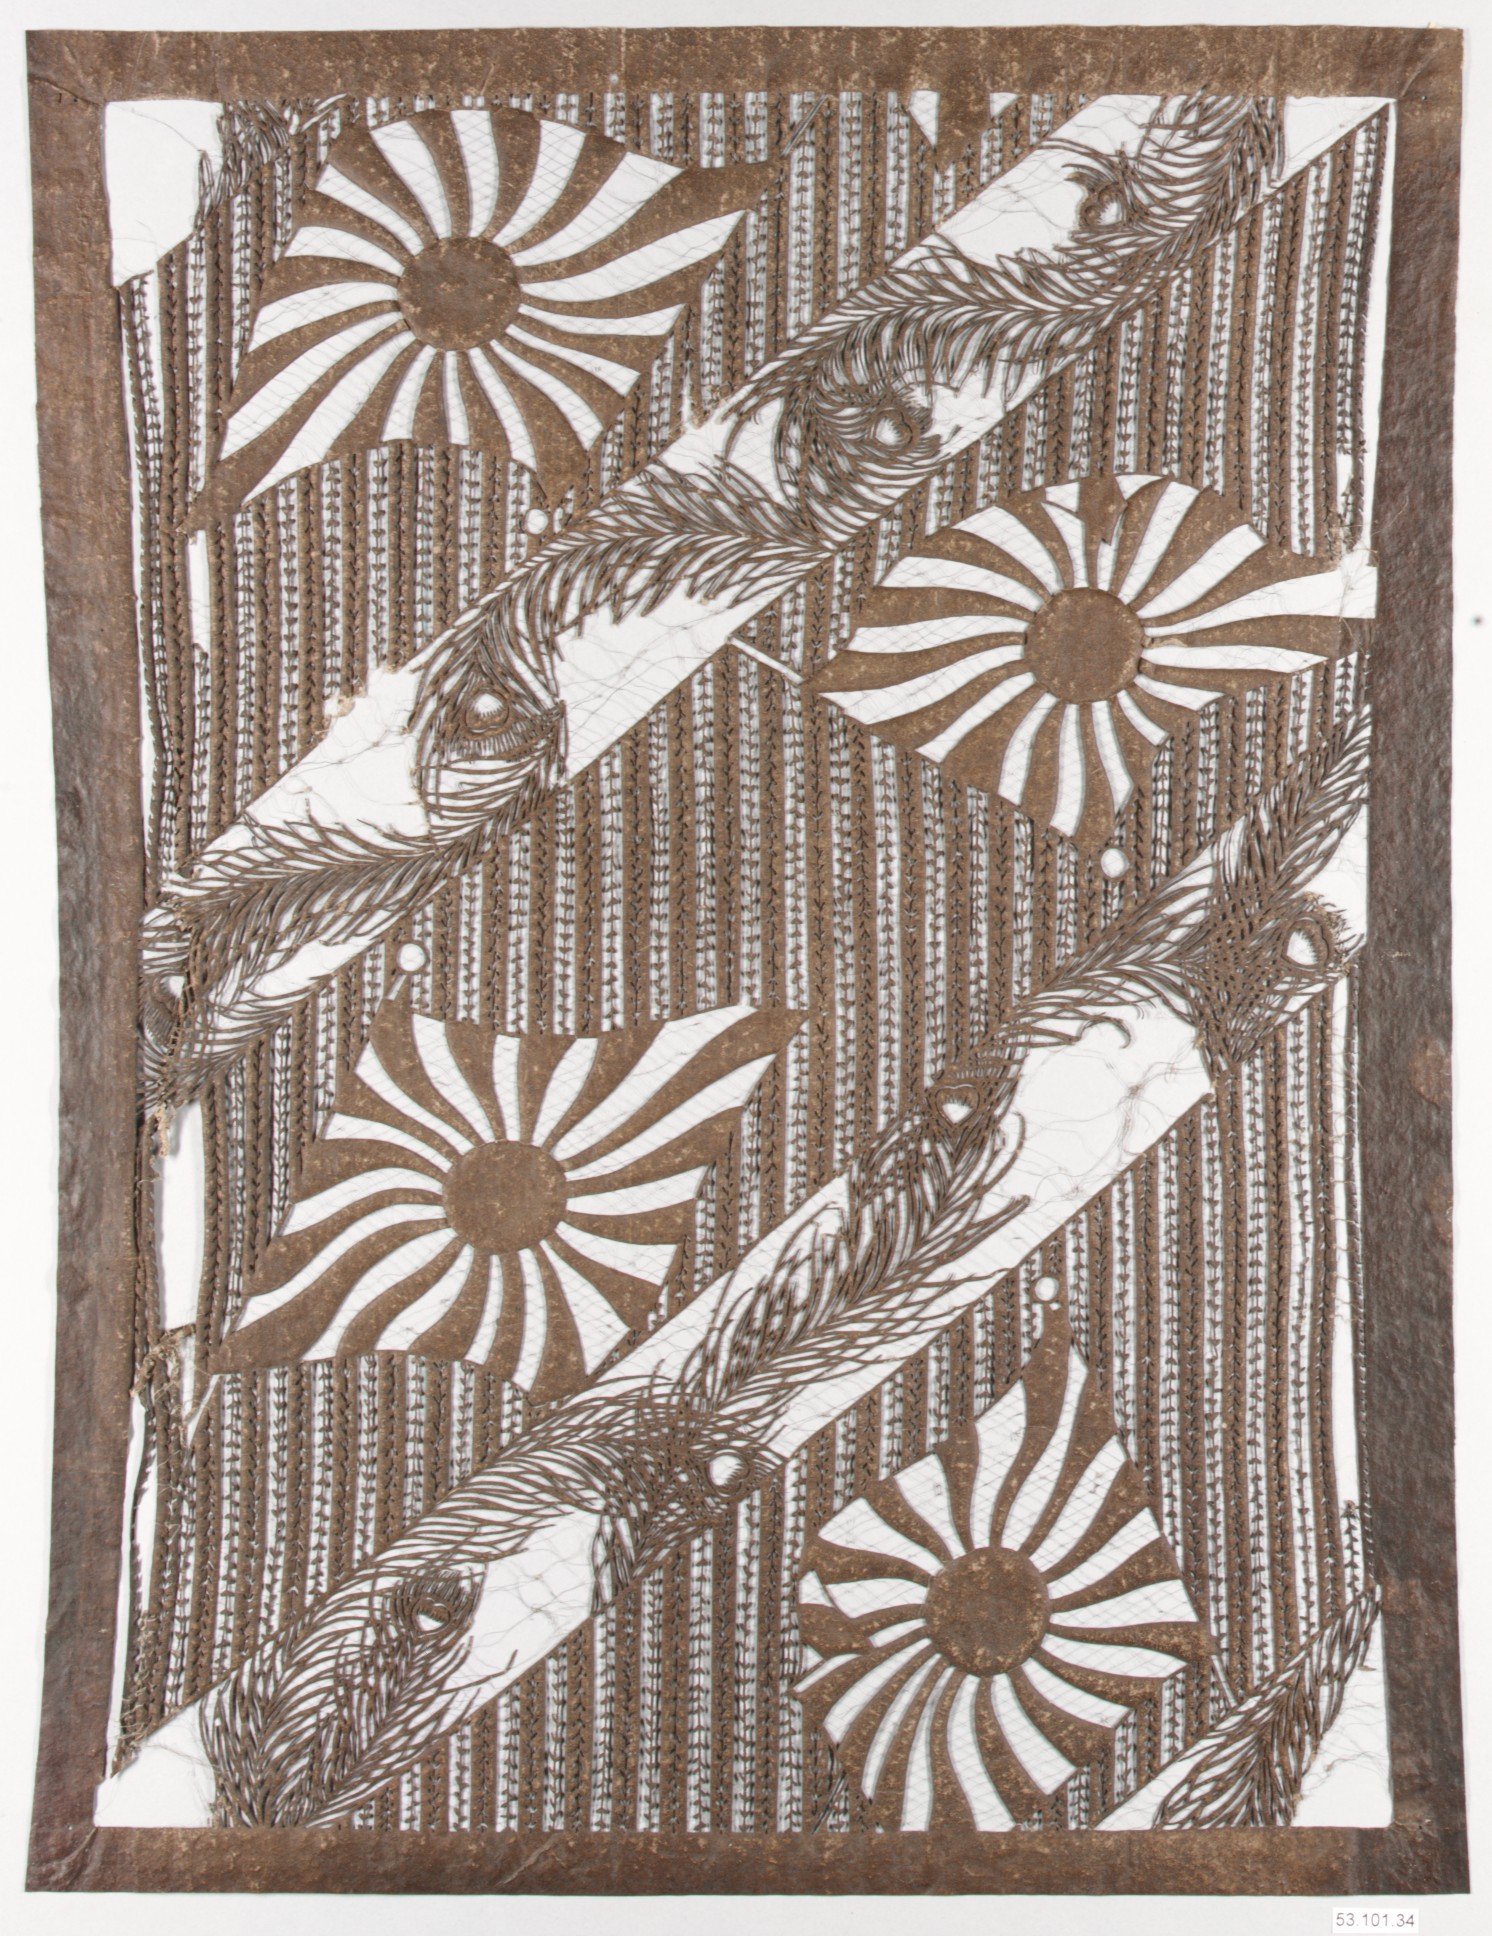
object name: stencil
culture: japanese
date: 1615-1868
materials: paper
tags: feathers,flags